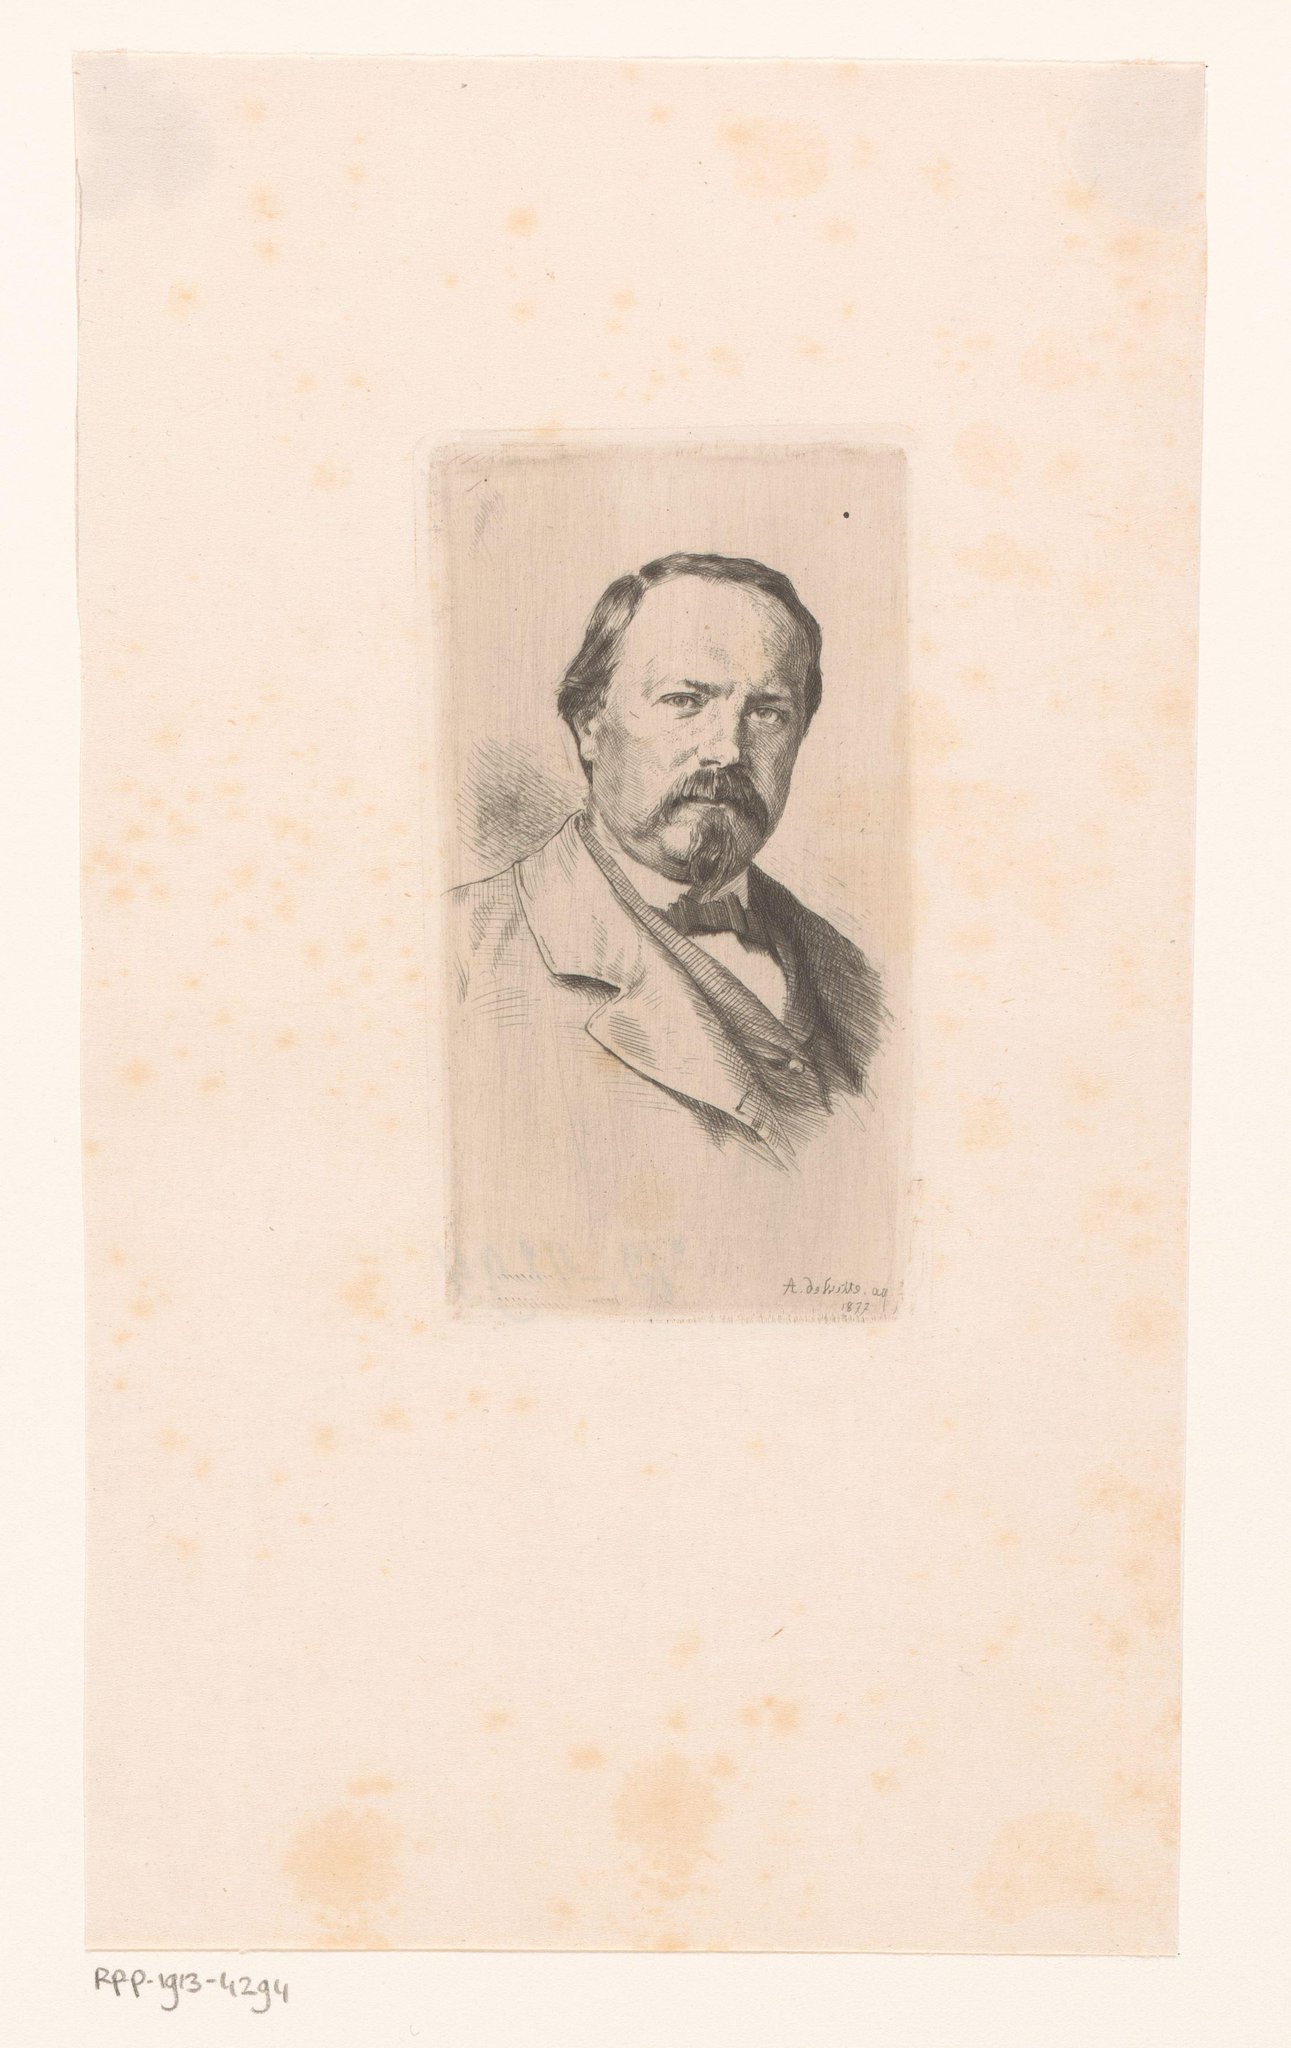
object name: print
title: Portret van Nicolas Defrêcheux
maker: adrien de witte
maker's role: print maker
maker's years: 1850-1935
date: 1877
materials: paper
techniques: etching, intaglio, retroussage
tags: moustache, adult man, historical persons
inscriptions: collector's mark: Lugt 2228